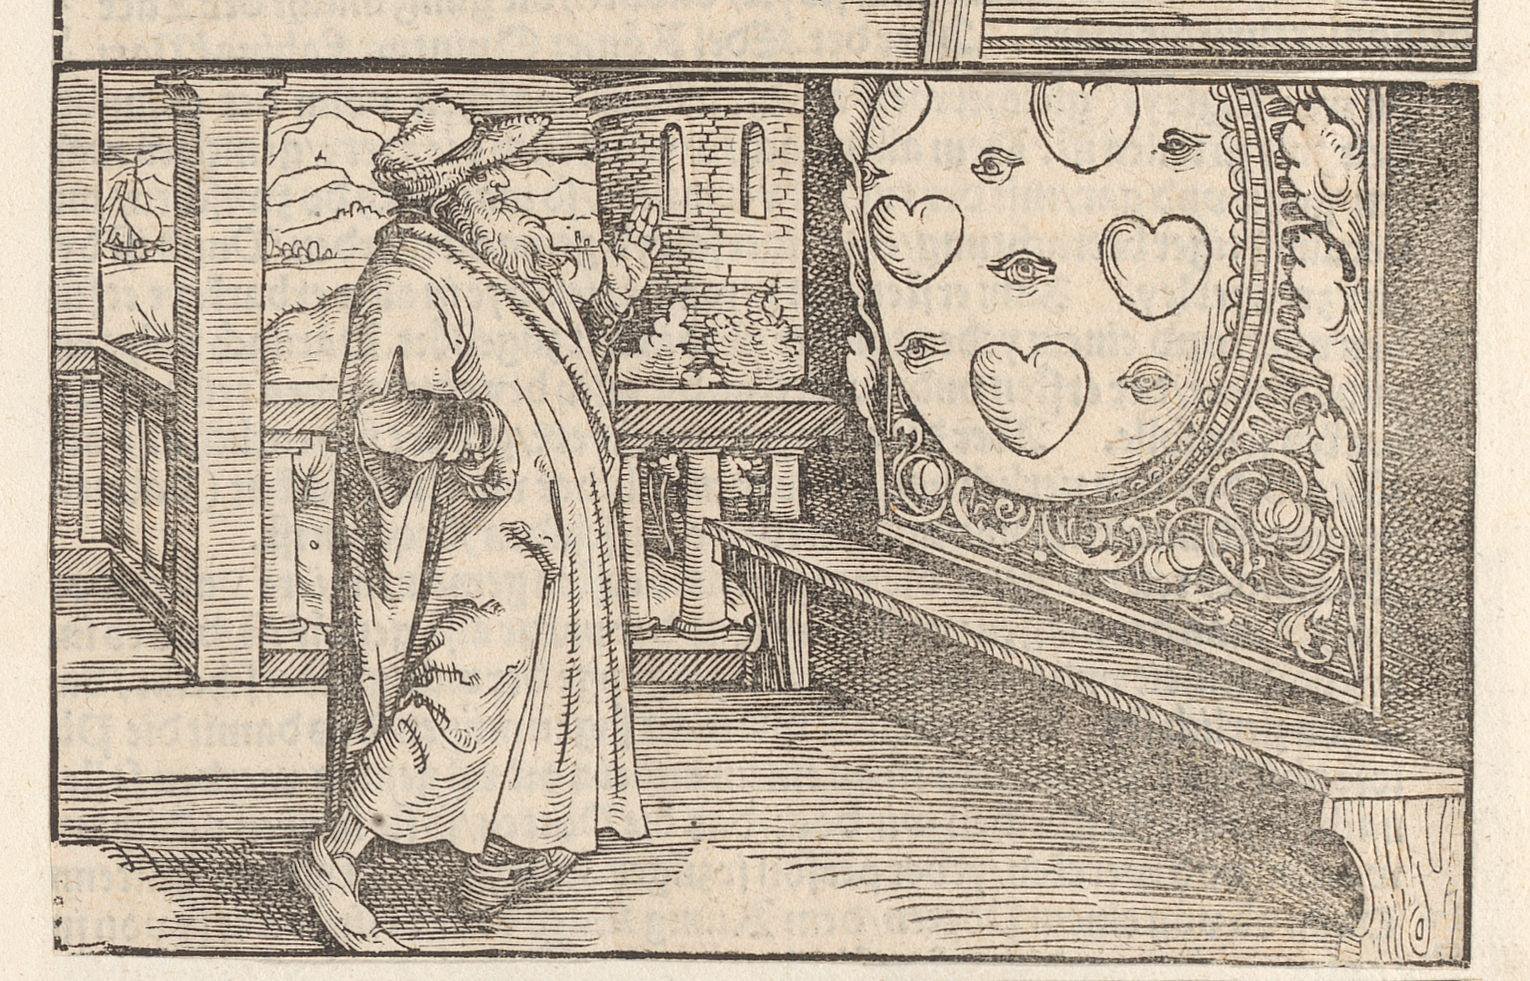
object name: print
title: Oude man voor een spiegel met harten en ogen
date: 1514-1531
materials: paper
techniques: letterpress printing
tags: looking in the mirror; (possibly: contemplation of own beauty - aa - (for) women), good and bad behaviour, moral qualities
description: Deze prent is gebruikt in: Cicero, Marcus Tulius. Officia M.T.C. Ein Buch so Marcus Tullius Cicero der Römer zu seynem (...). [Vertaald uit het Latijn door] Johann von Schwarzenberg. Augsburg: Heinrich Steiner, 1531. Mogelijk staan de harten met ogen voor het verschil tussen het uiterlijk en het innerlijke of zijn een verwijzing naar Efeziërs 1:18, waarin het openstellen van het hart de verlichte zienswijze is.